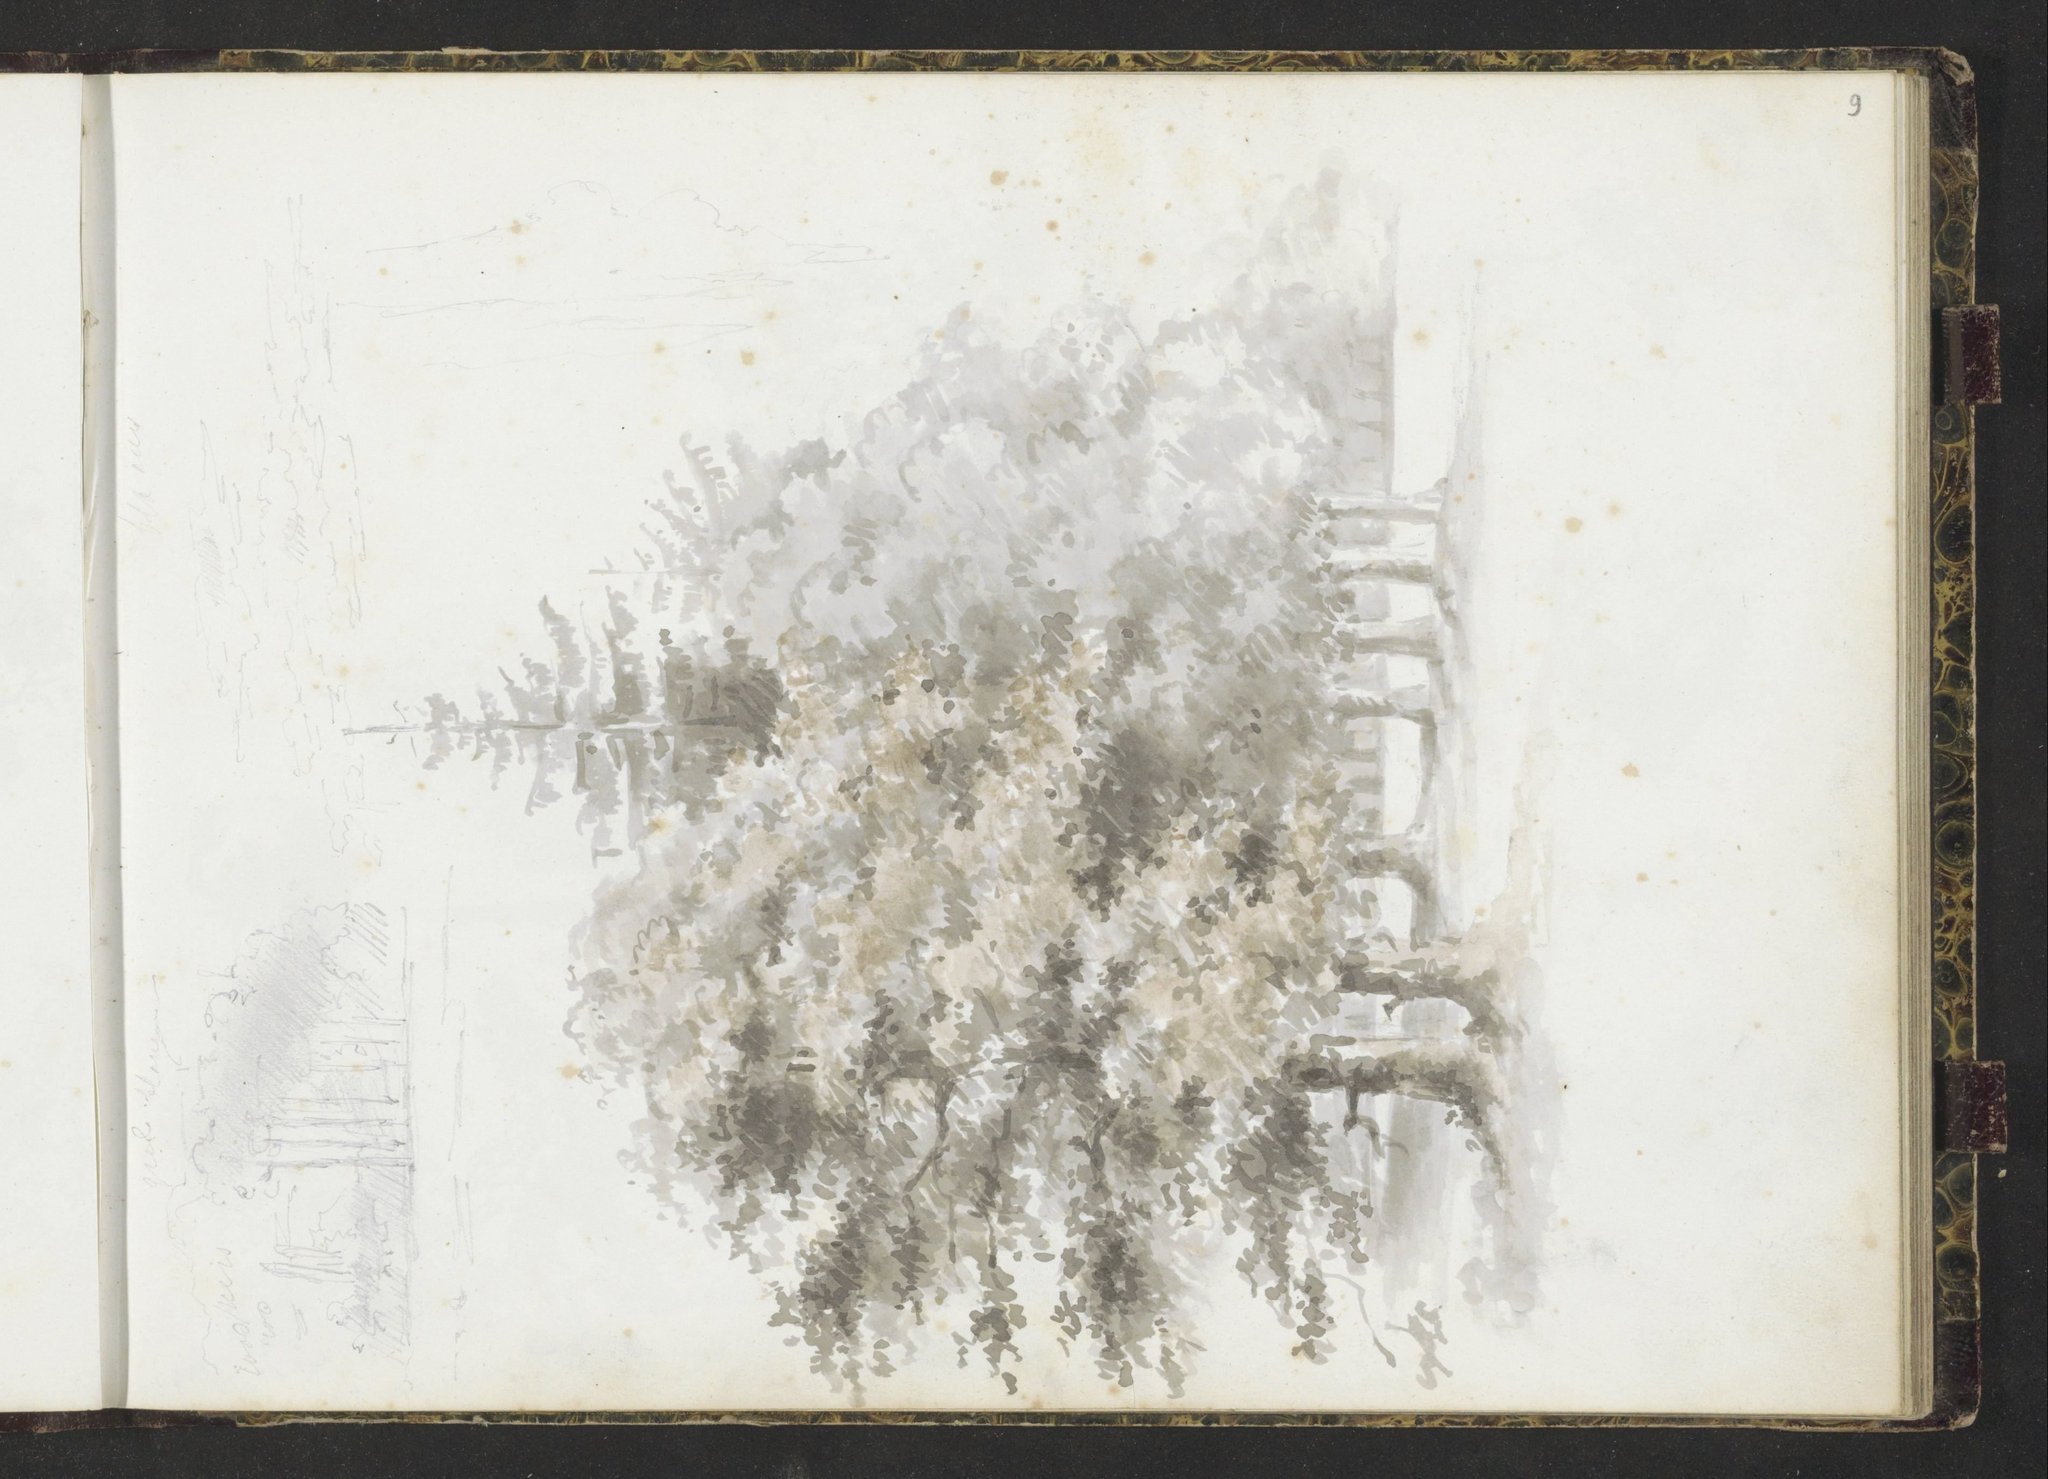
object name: sketchbook leaf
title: Bosrand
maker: lambertus lingeman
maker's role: draughtsman, painter, print maker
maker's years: 1829-1894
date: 1839-1894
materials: paper, pencil, watercolor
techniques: brush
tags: fringe, edge of the wood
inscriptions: kleurnotitie, handgeschreven in potlood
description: Blad 9 recto uit een schetsboek met 51 bladen.